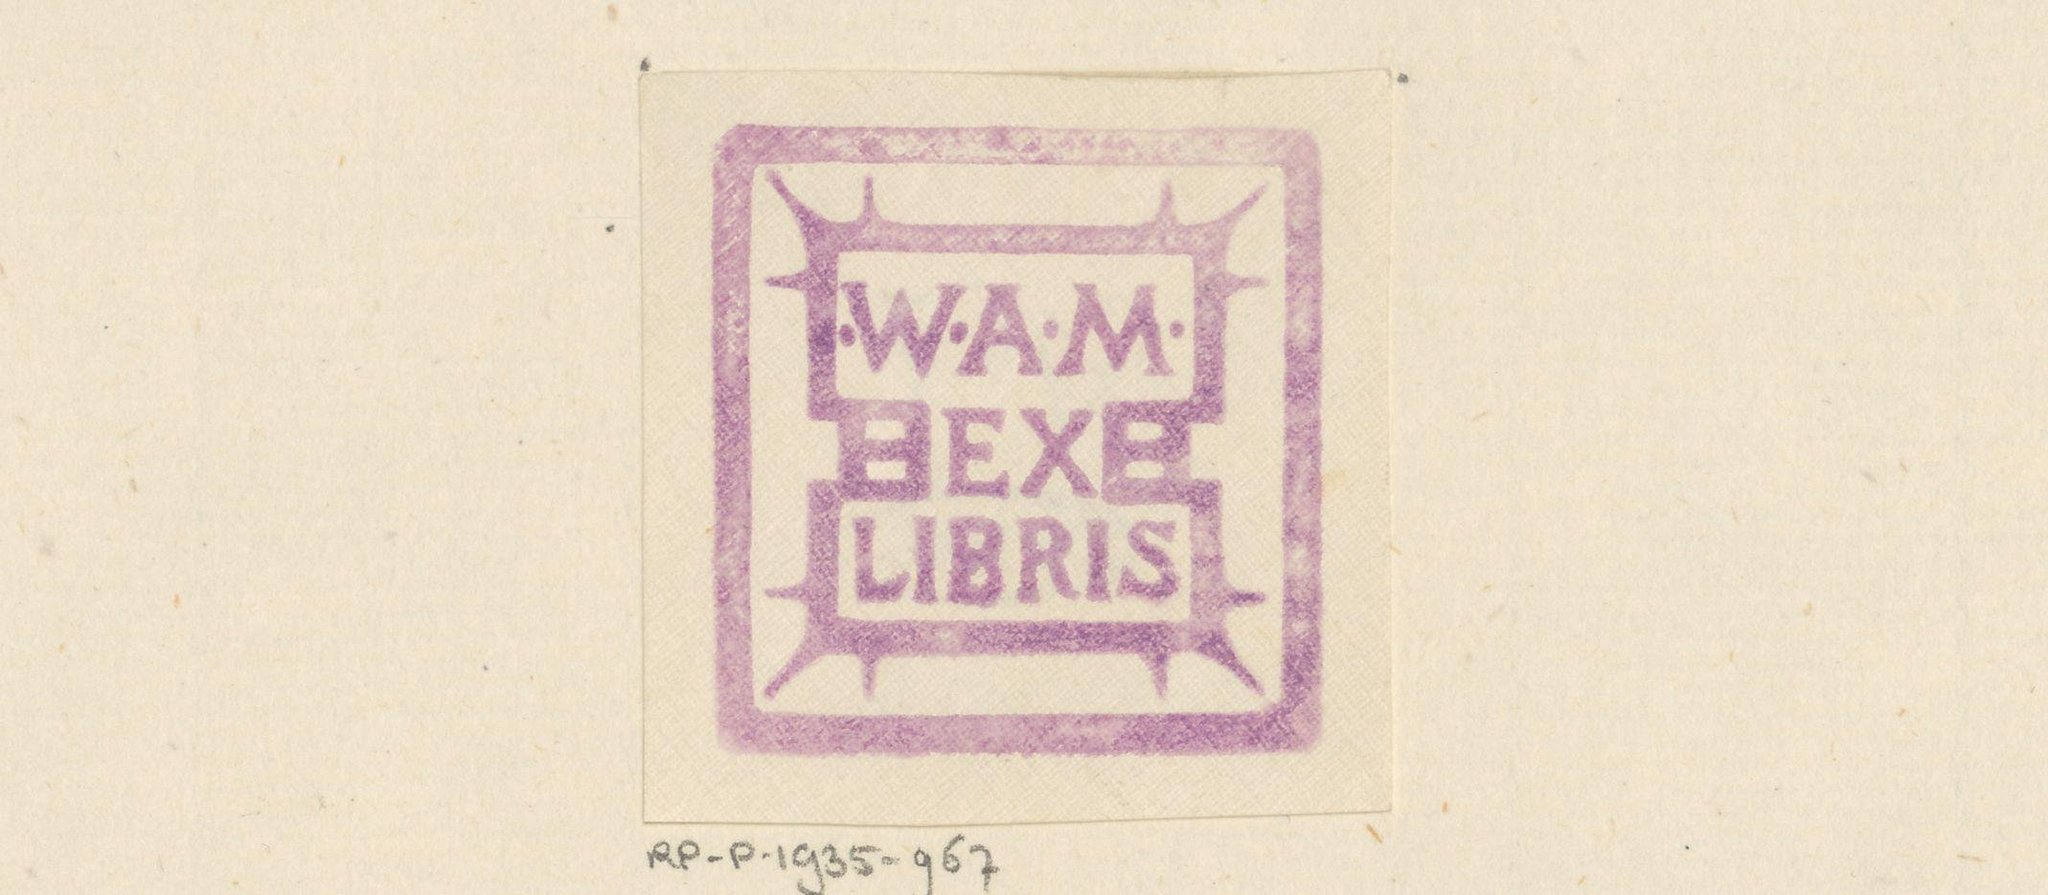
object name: bookplate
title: Ex libris van W.A. Mees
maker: julie de graag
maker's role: draughtsman, print maker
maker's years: 1877-1924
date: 1887-1924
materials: paper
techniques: woodcut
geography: netherlands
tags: jurist, wijnand adriaan mees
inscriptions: collector's mark: Lugt 2228